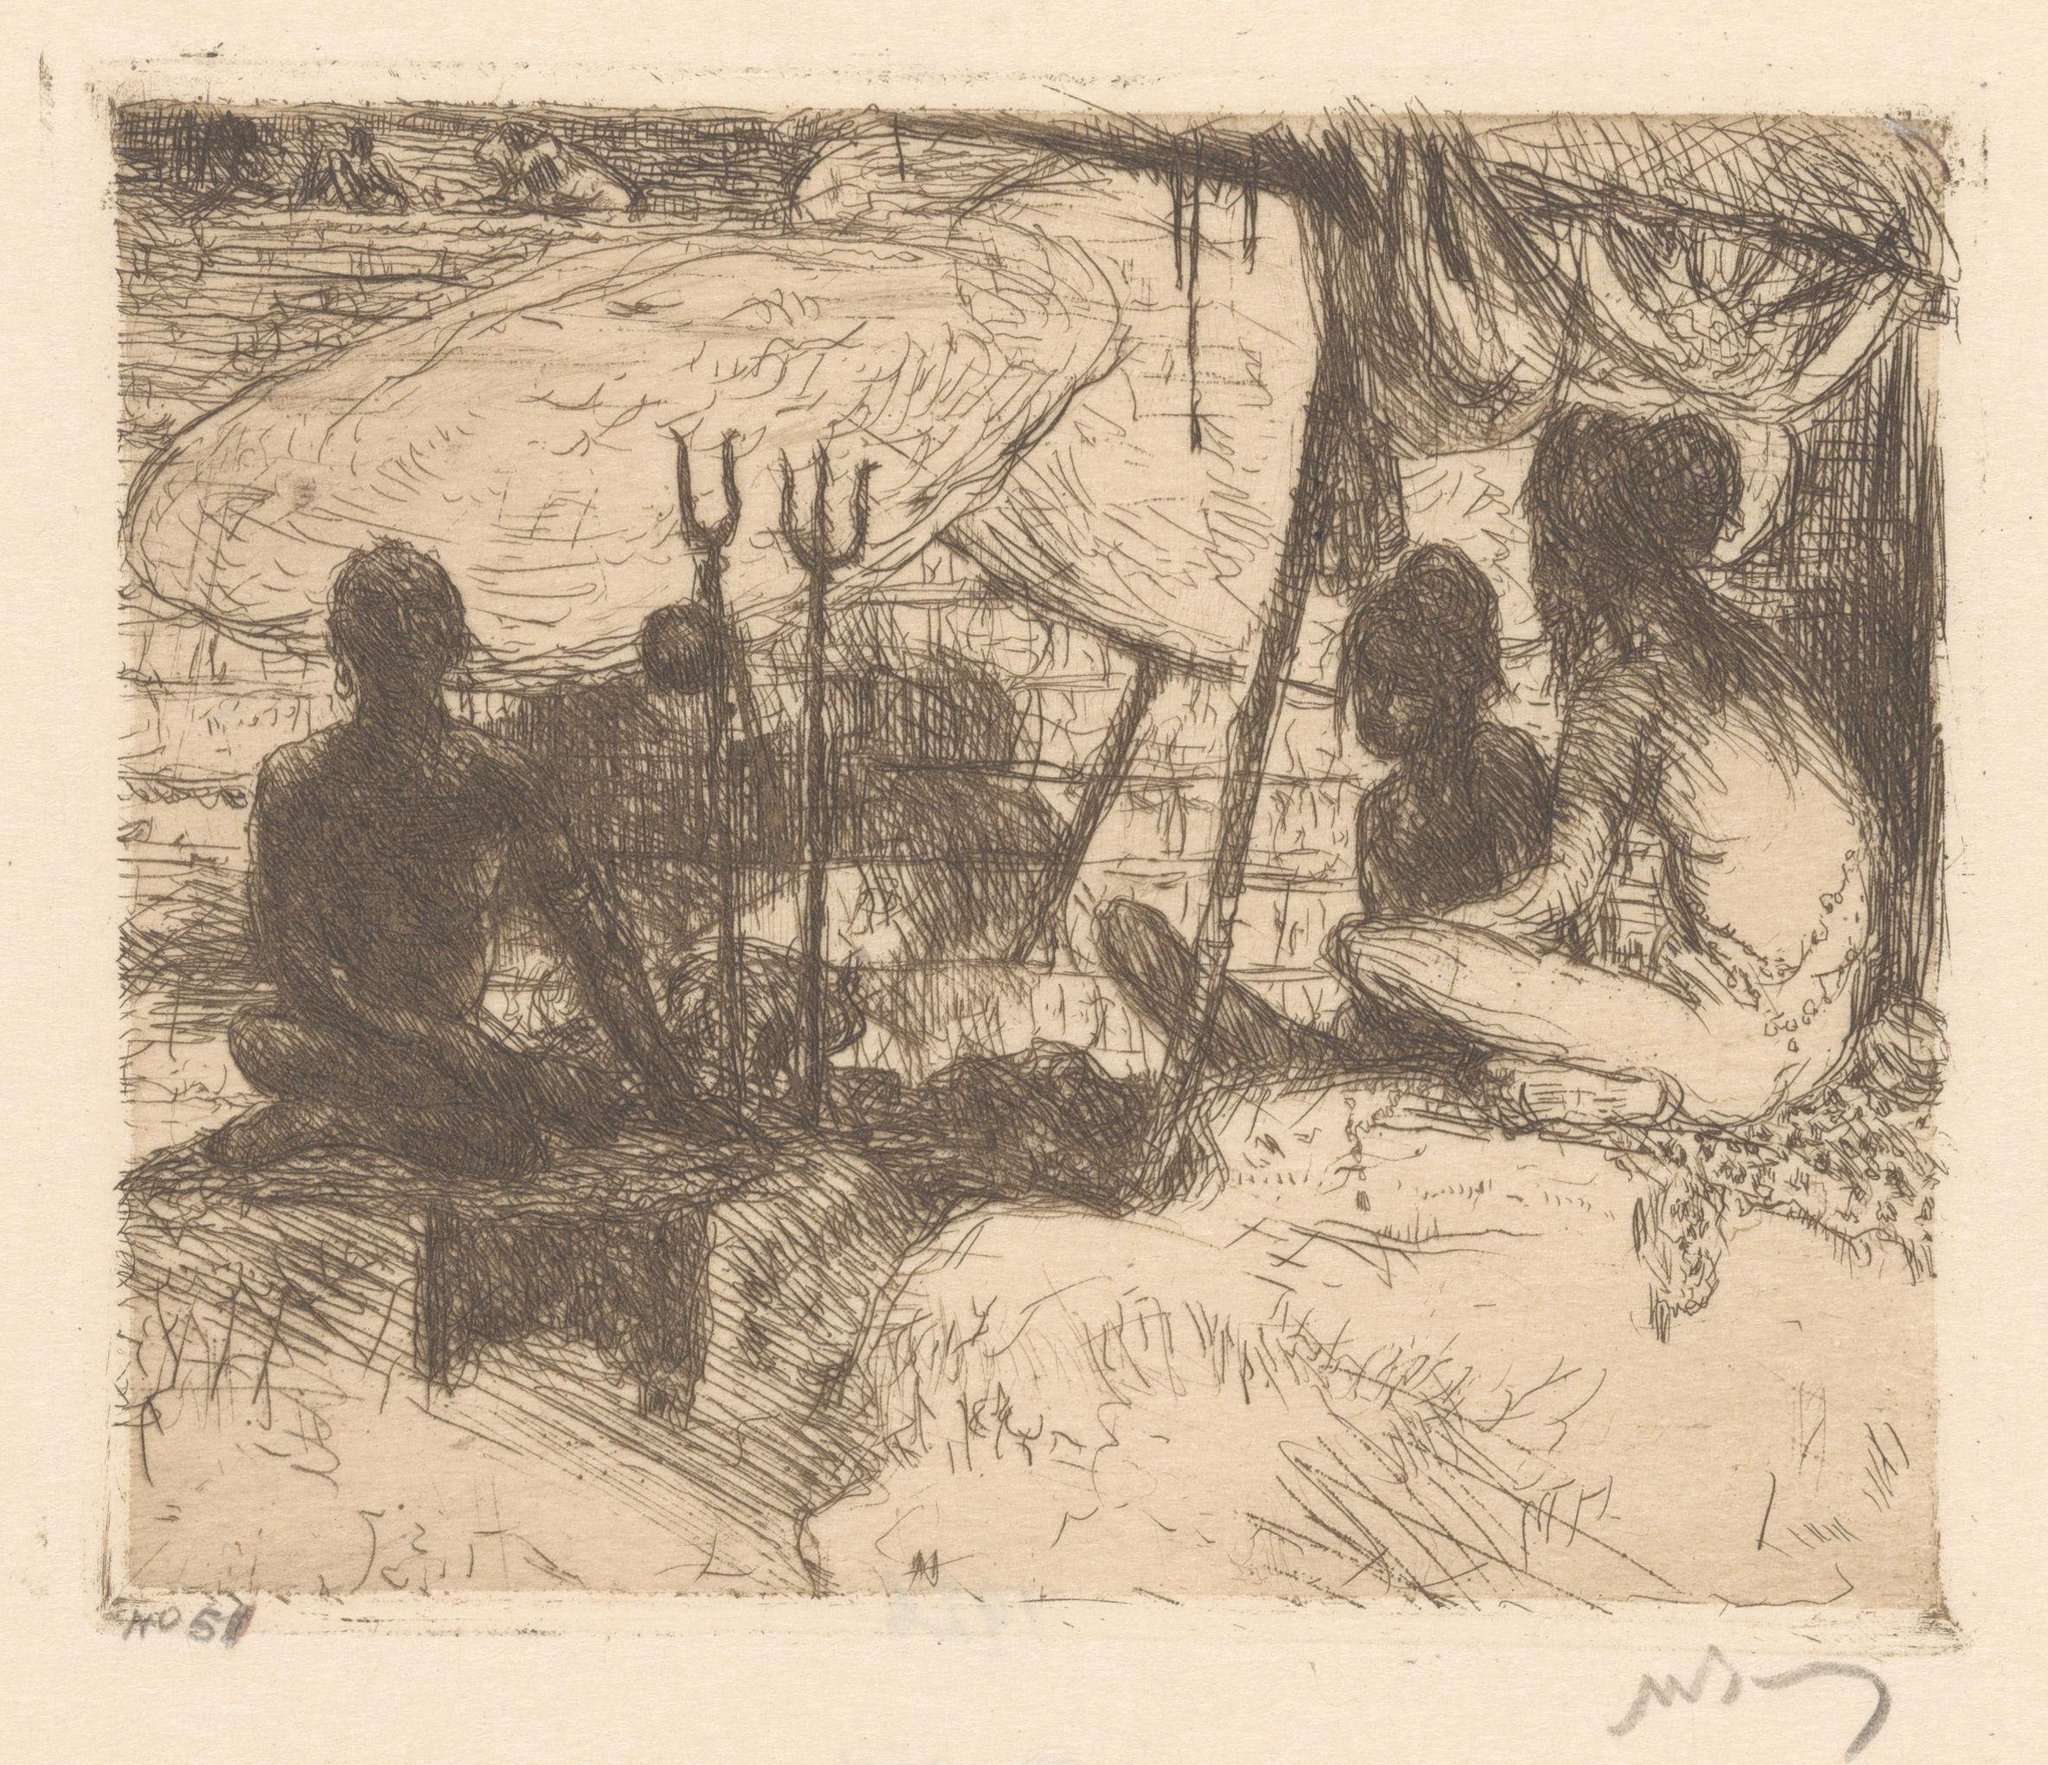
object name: print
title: Waarzegger in Brits-Indië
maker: marius bauer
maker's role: draughtsman, print maker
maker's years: 1867-1932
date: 1926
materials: paper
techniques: etching, intaglio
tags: fortune-teller ~ pleasure fair and circus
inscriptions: collector's mark: Lugt 2228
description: Een groep van drie figuren in kleermakerszit. Boven elk van hen een parasol.